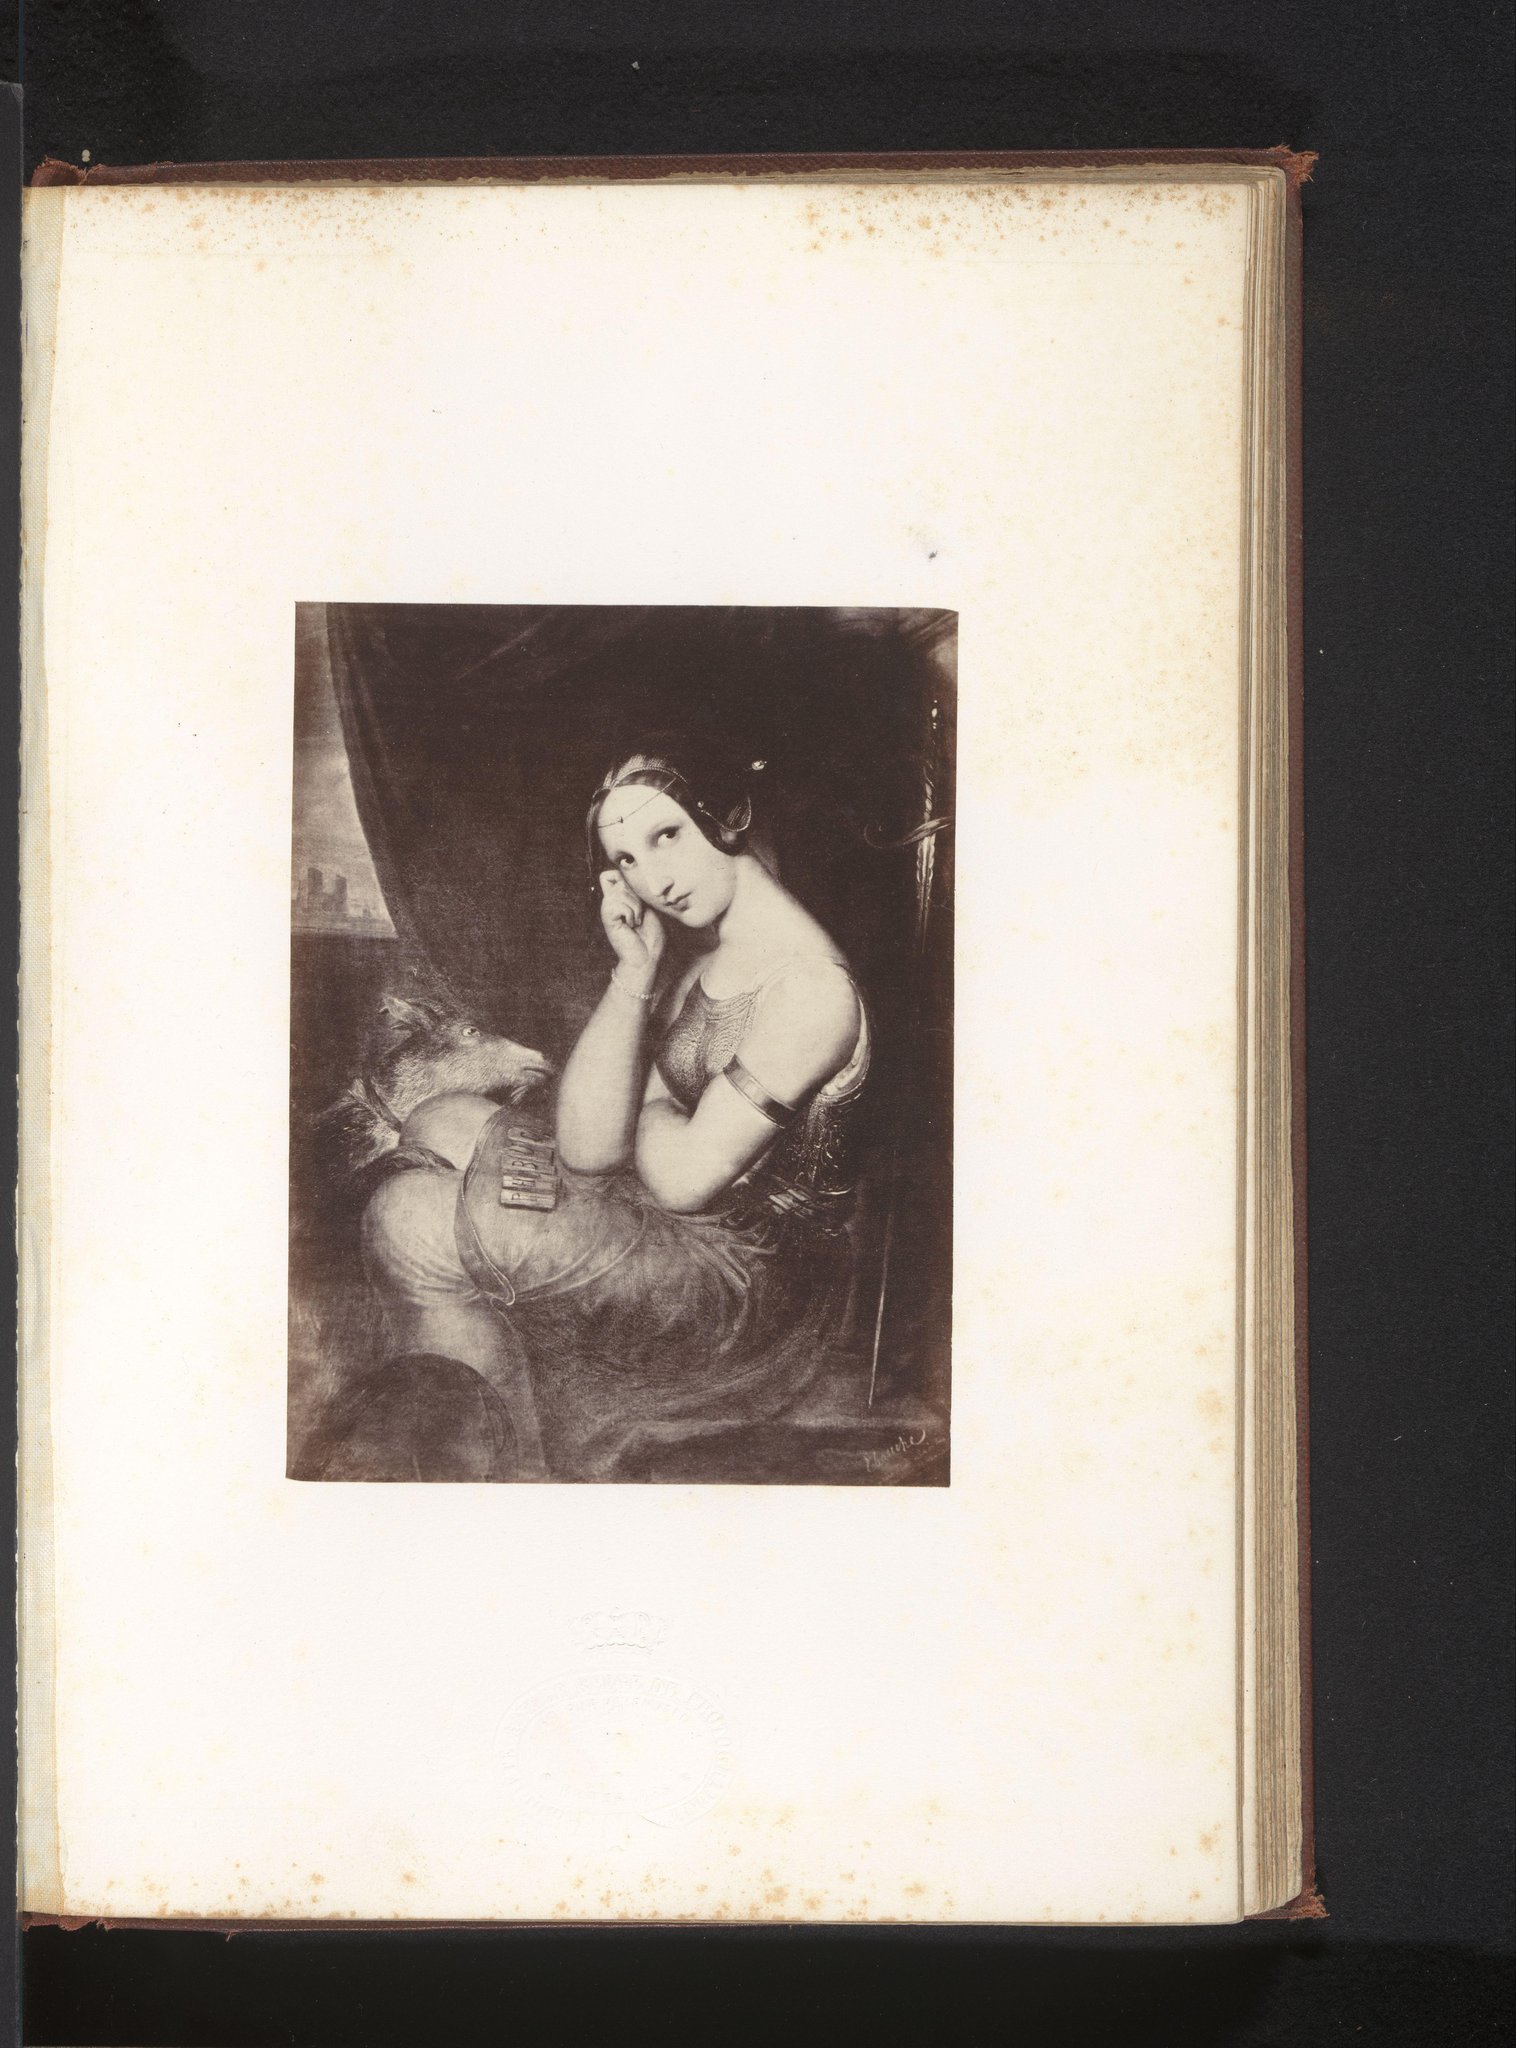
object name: photograph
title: Fotoreproductie van Esmeralda door Antoine Wiertz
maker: edmond fierlants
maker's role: fotograaf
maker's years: 1819-1869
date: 1863-1868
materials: photographic support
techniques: albumen print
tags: historical persons not known by name - bb - woman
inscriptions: check stamp: ‘SOCIÉTÉ ROYALE BELGE DE PHOTOGRAPHIE/ 69, RUE KEYENVELD/ BRUXELLES’